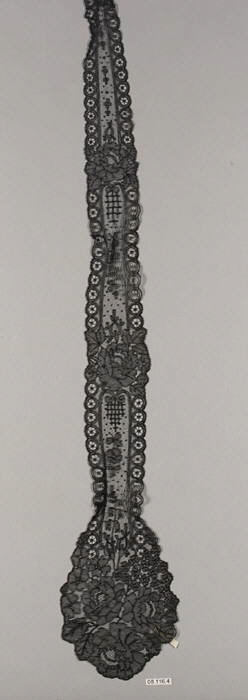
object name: barbe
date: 1801-1900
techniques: lace